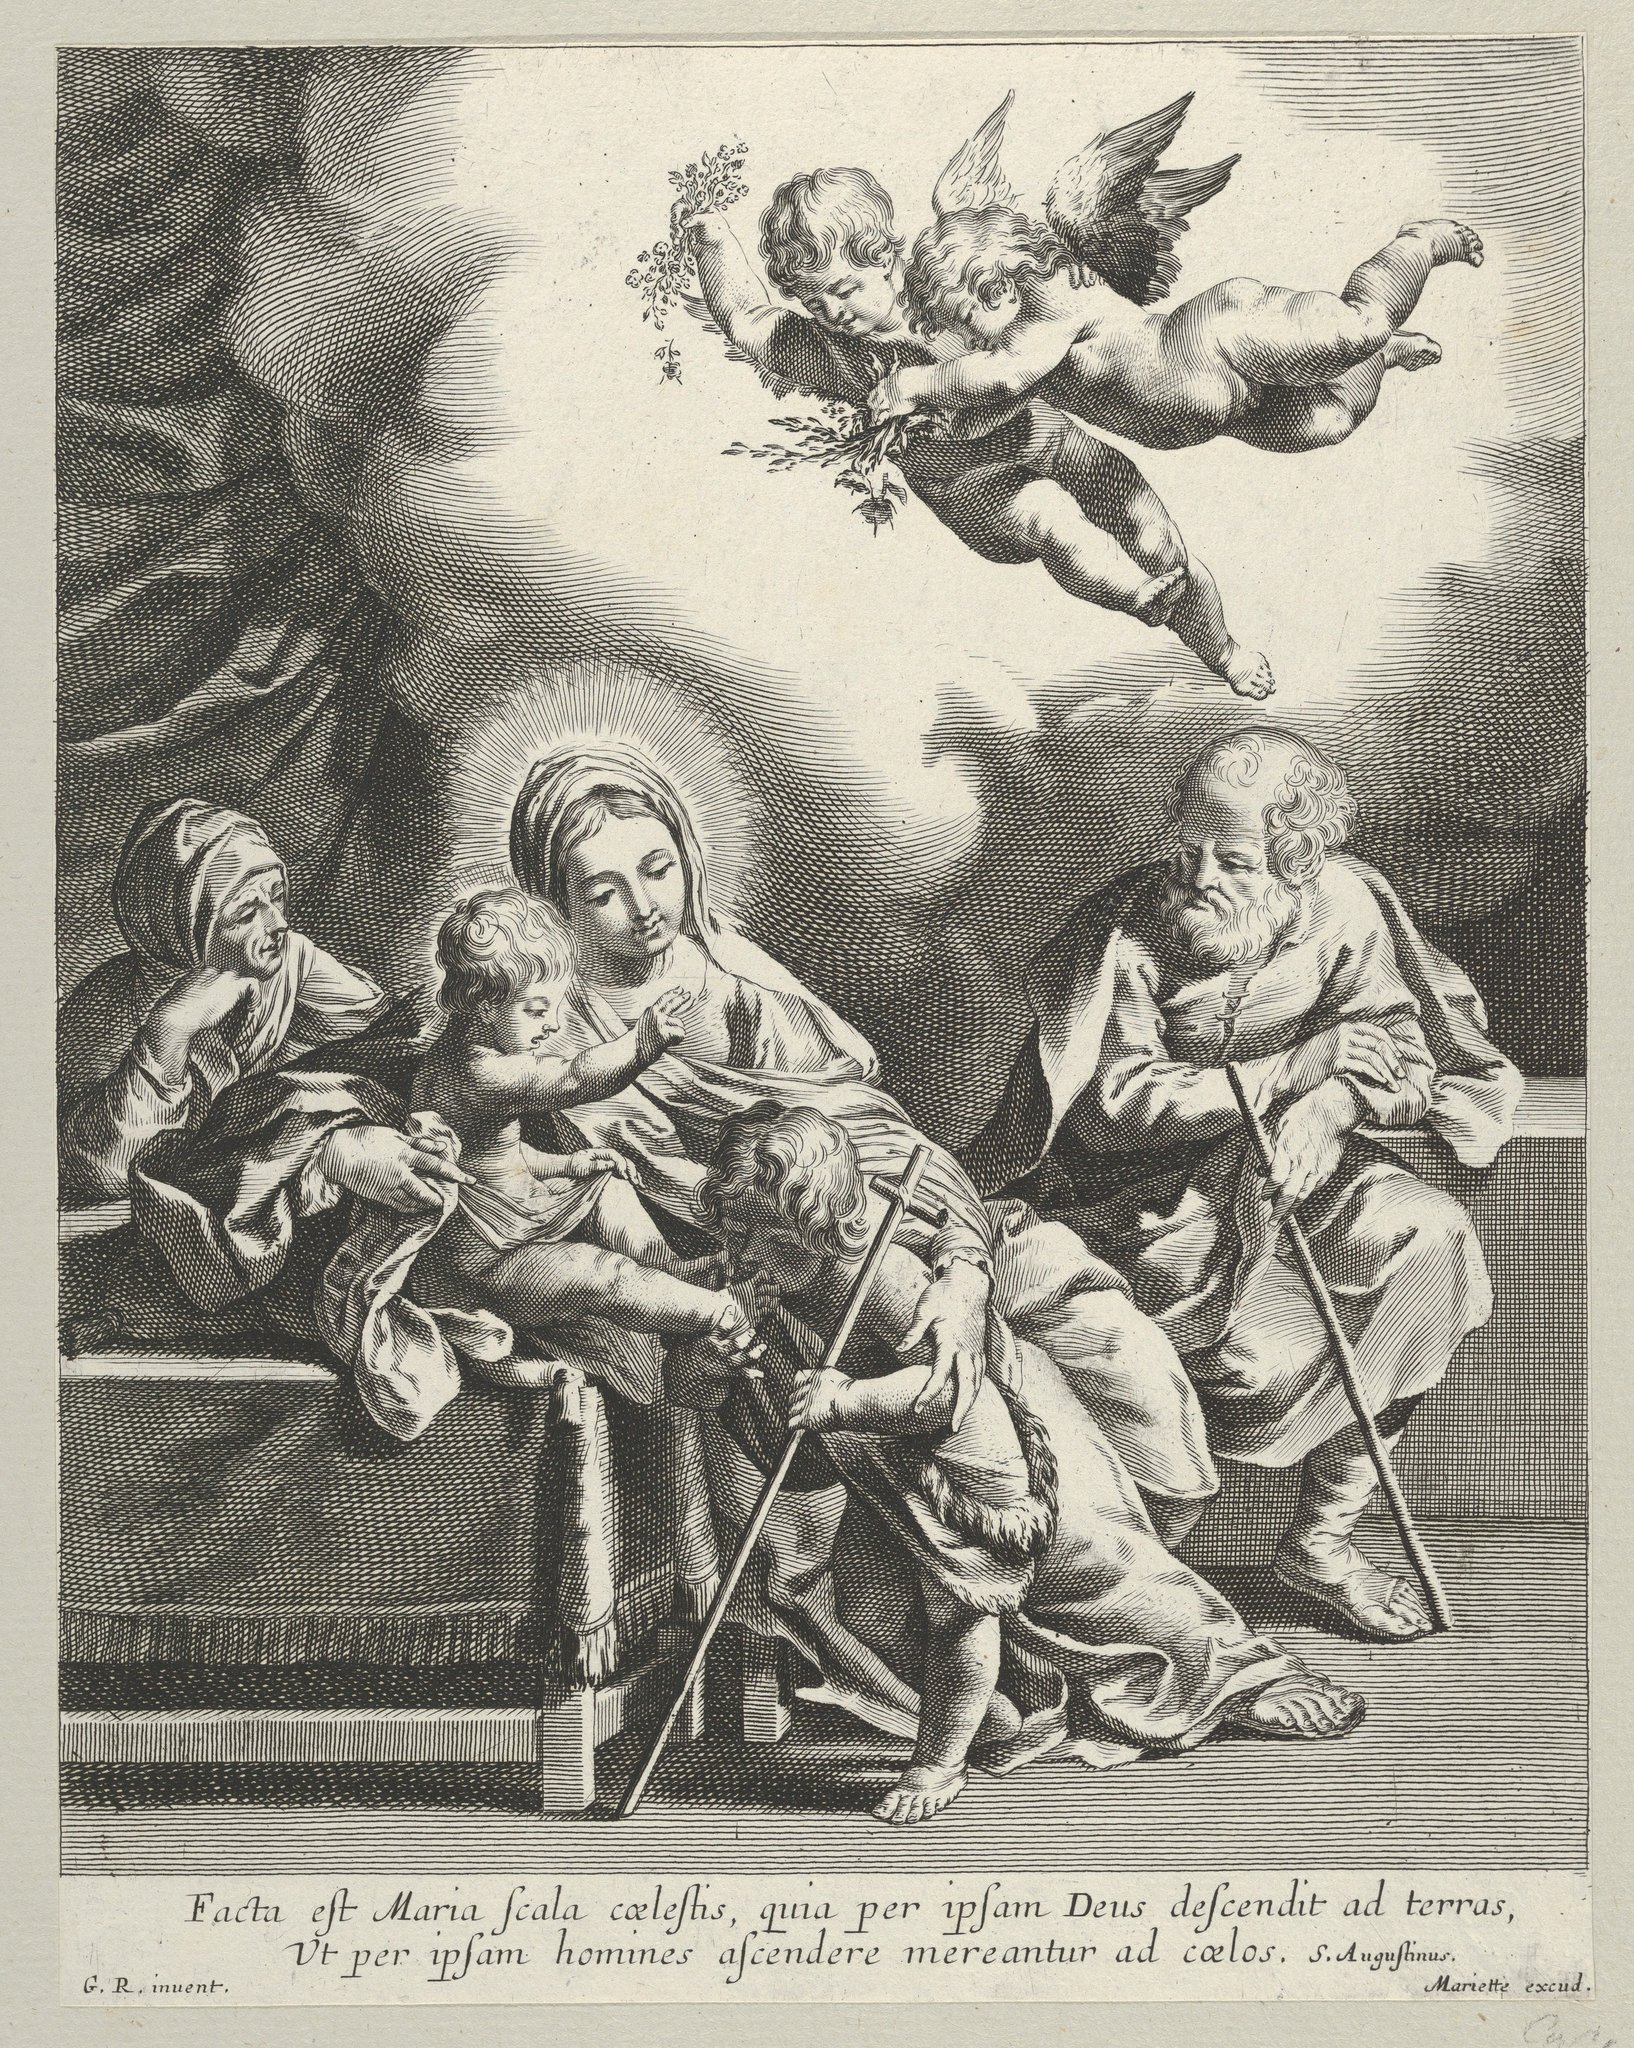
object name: print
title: The Holy Family with young John the Baptist and Saint Elizabeth, two angels above, after Reni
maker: anonymous, 17th century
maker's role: artist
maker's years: 1600-1700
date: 1600-1640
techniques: engraving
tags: angels,christ,holy family,saint john the baptist,virgin mary